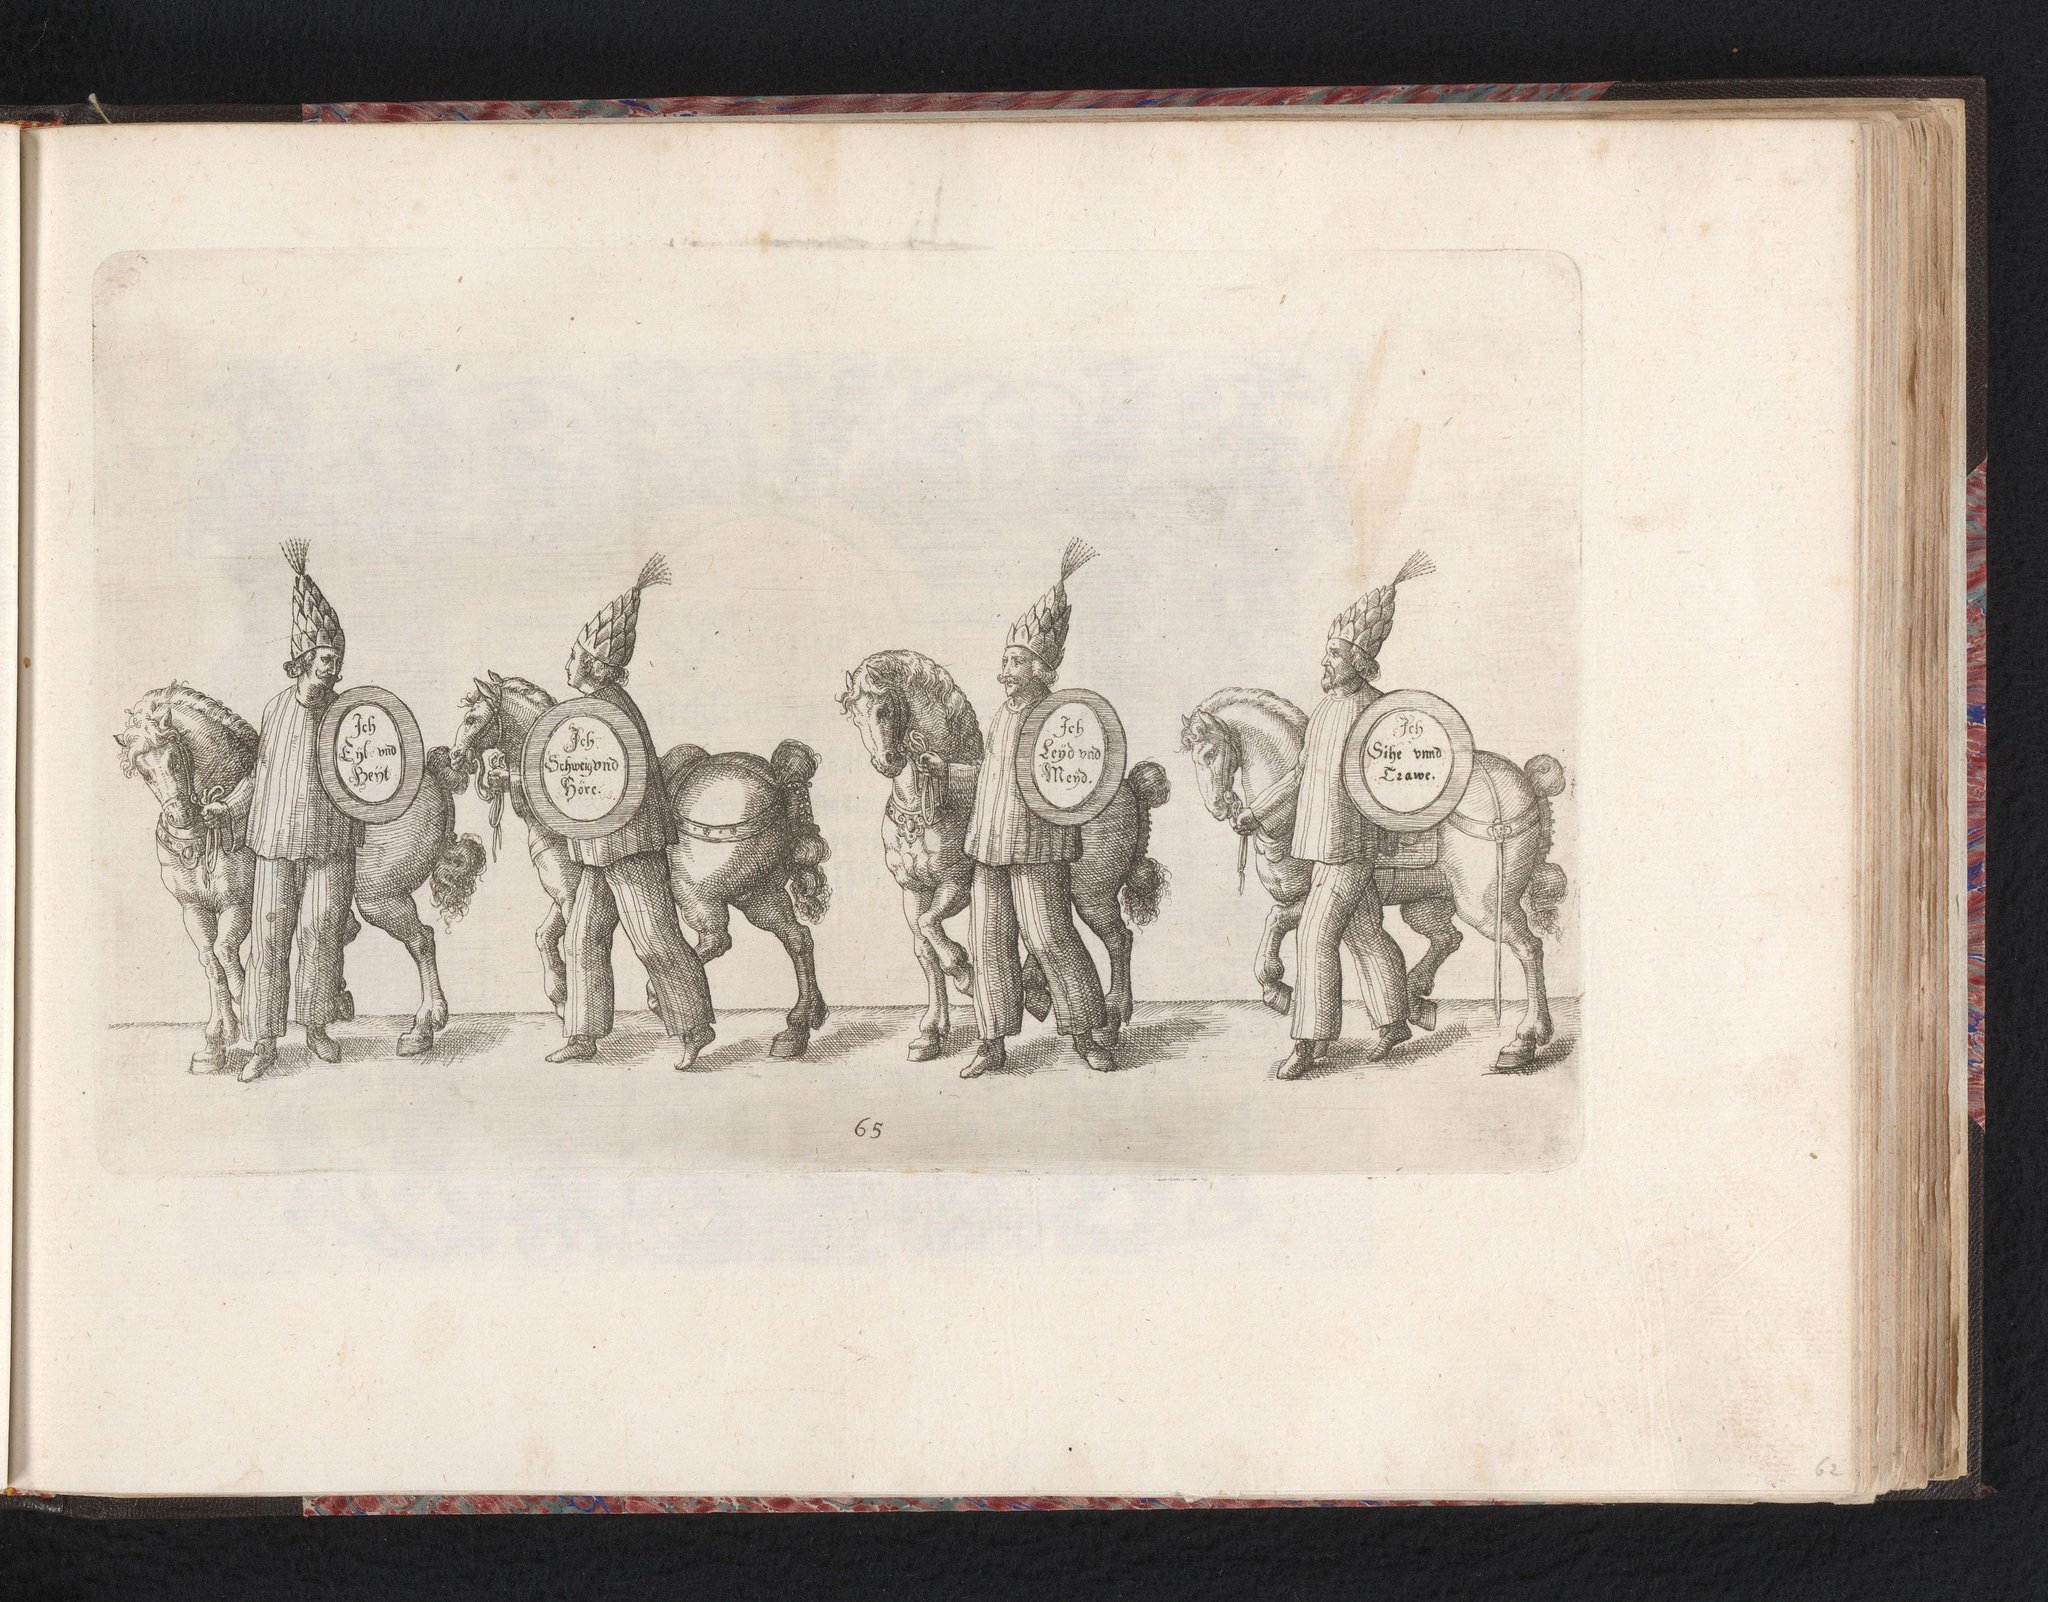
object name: album leaf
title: Aigentliche wahrhaffte Delineation unnd Abbildung aller fürstlichen Auffzüg und Rütterspilen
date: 1618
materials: paper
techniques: etching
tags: performance in the open air (pleasure fair), horses (circus performance)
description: Genummerd: 64. Tekst in het Duits op de borden. Prent maakt deel uit van een album.